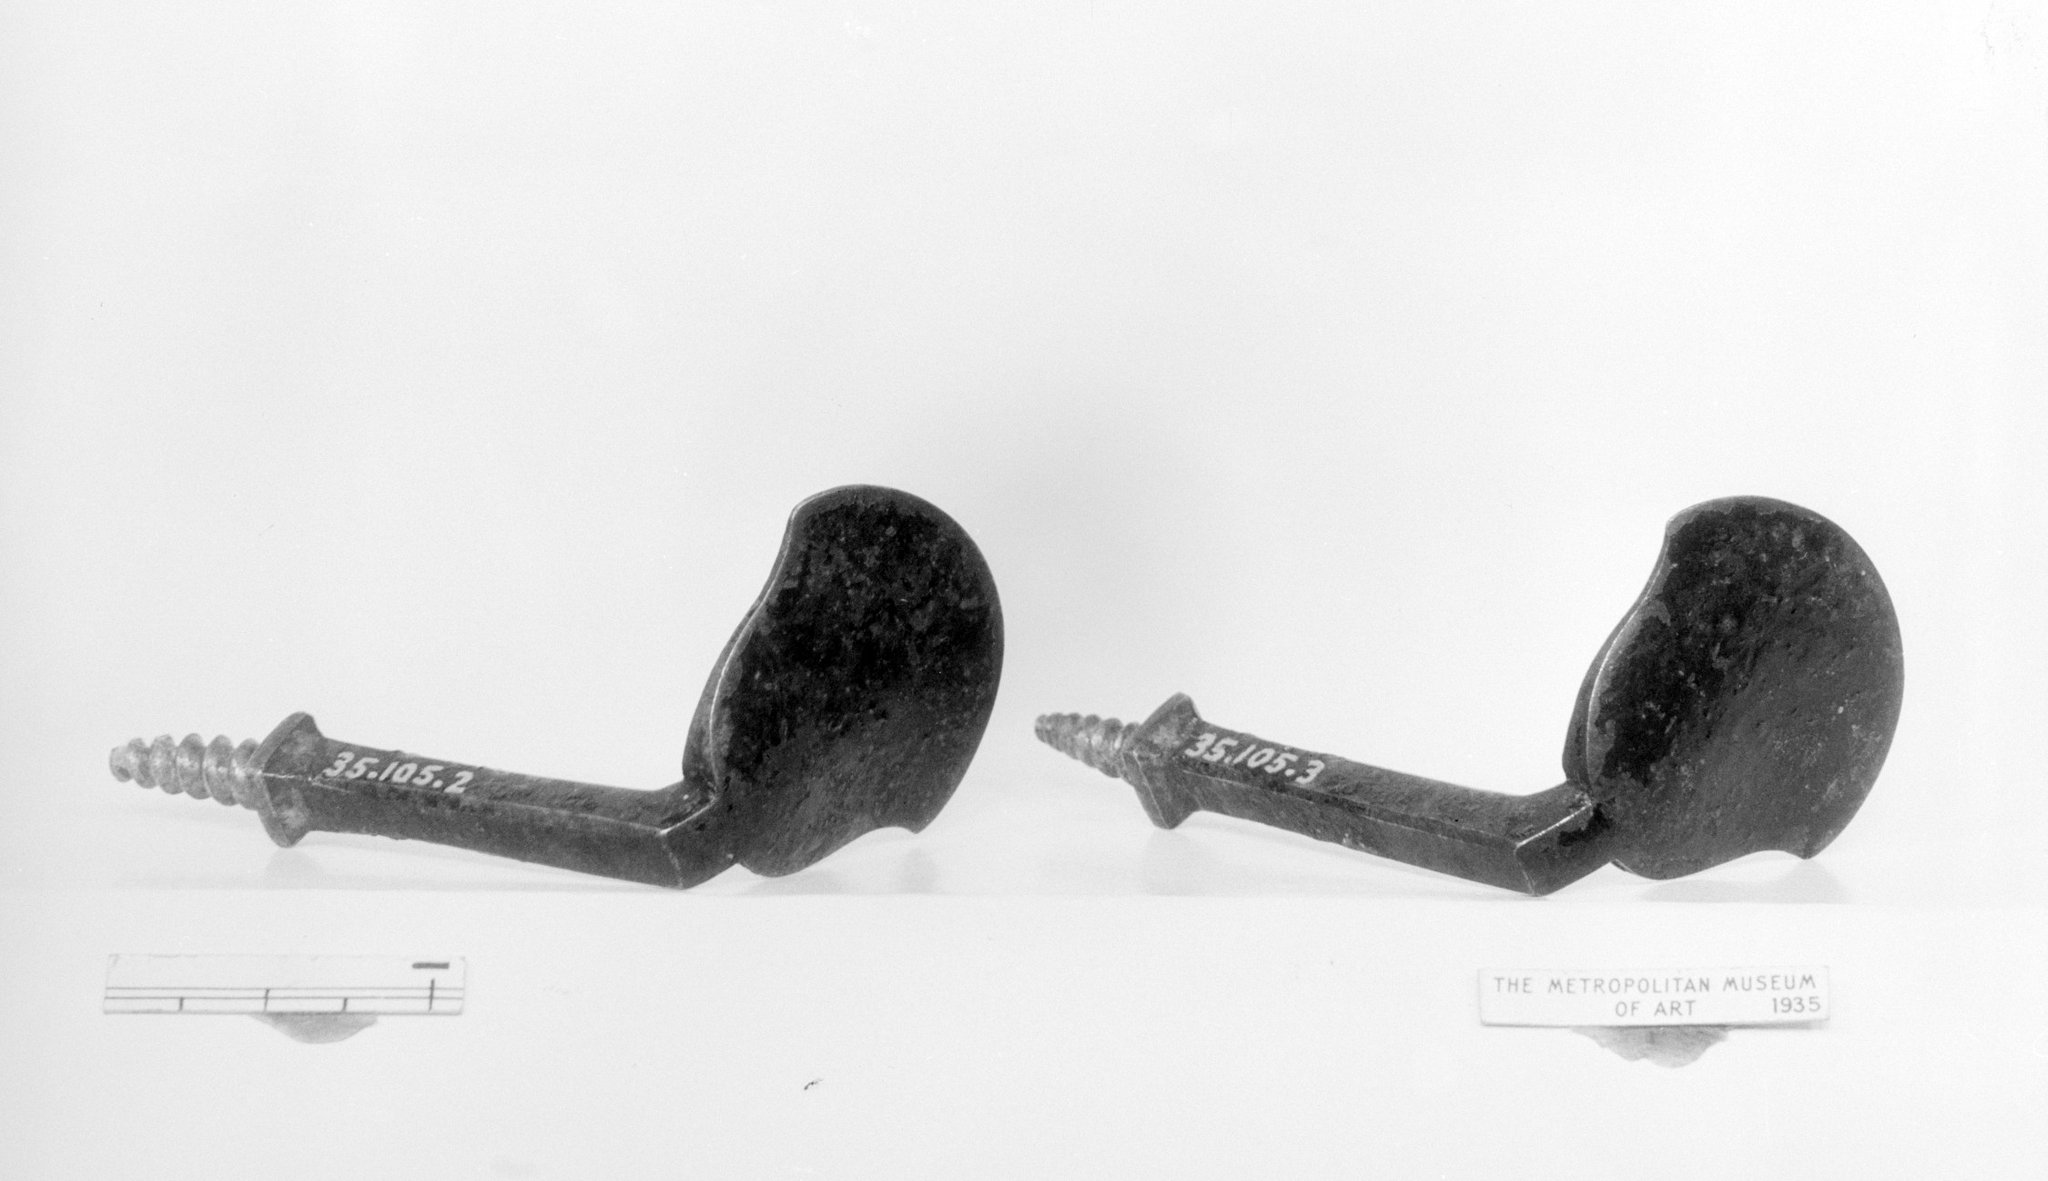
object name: gun hook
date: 1700-1800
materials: iron